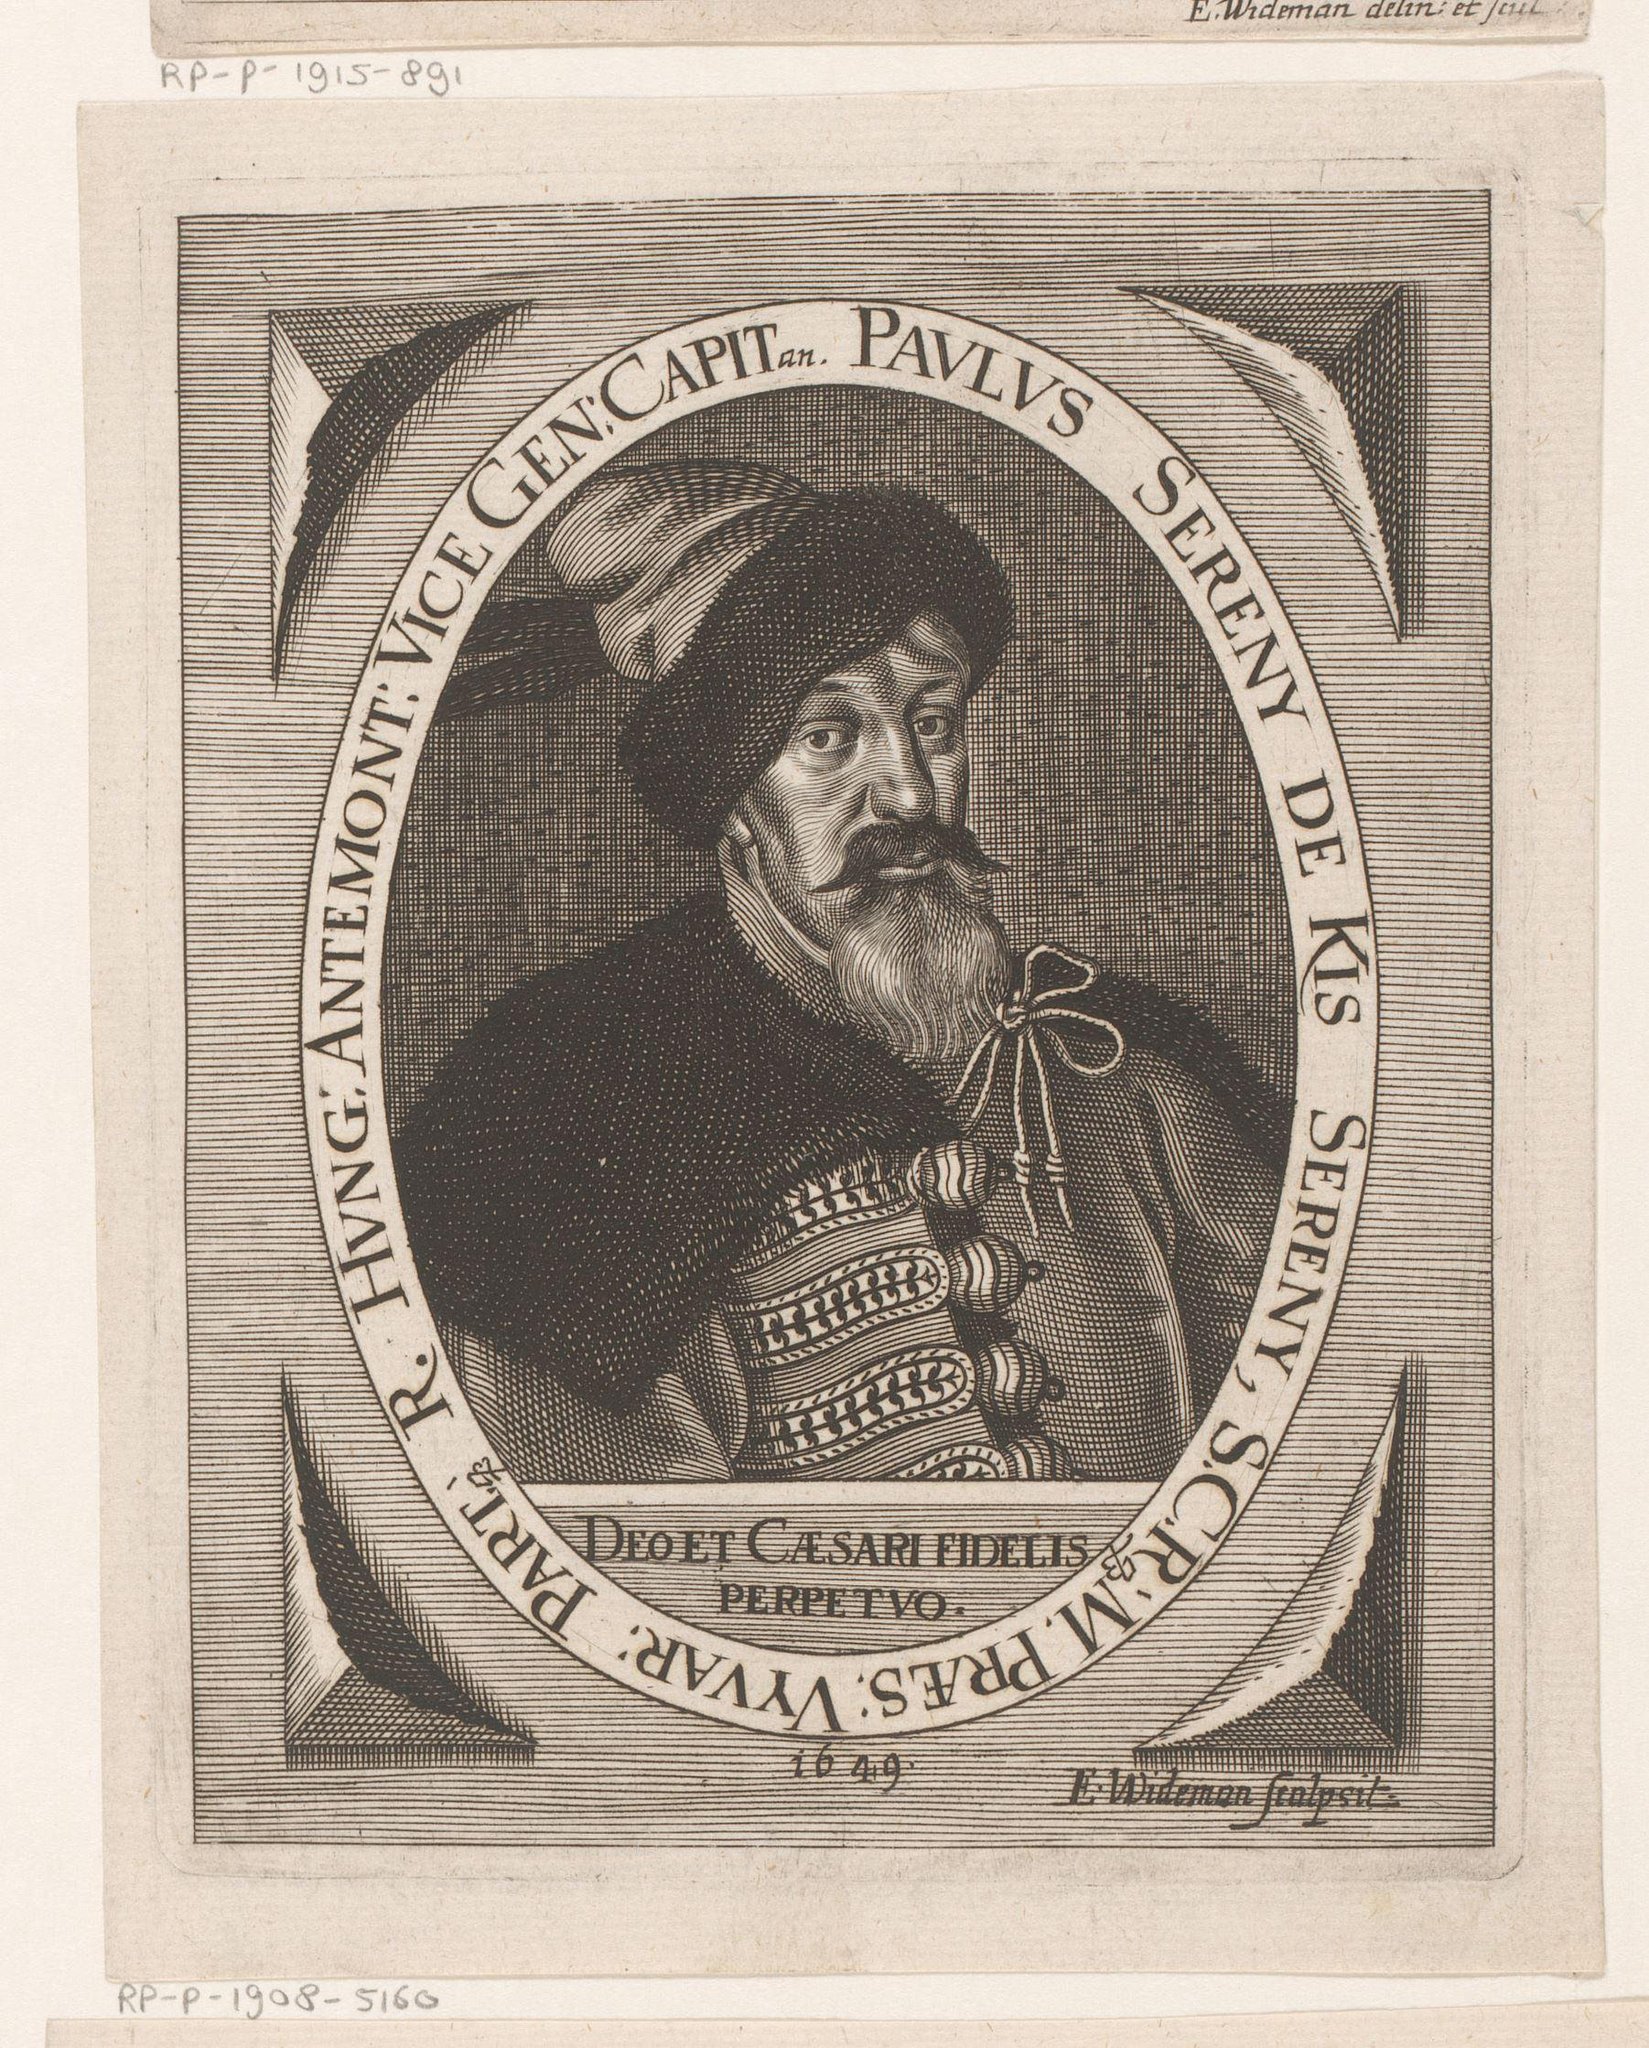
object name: print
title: Portret van Pál Serényi von Kis-Serény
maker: elias widemann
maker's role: print maker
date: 1649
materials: paper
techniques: engraving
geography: vienna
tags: historical persons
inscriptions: collector's mark: Lugt 2228